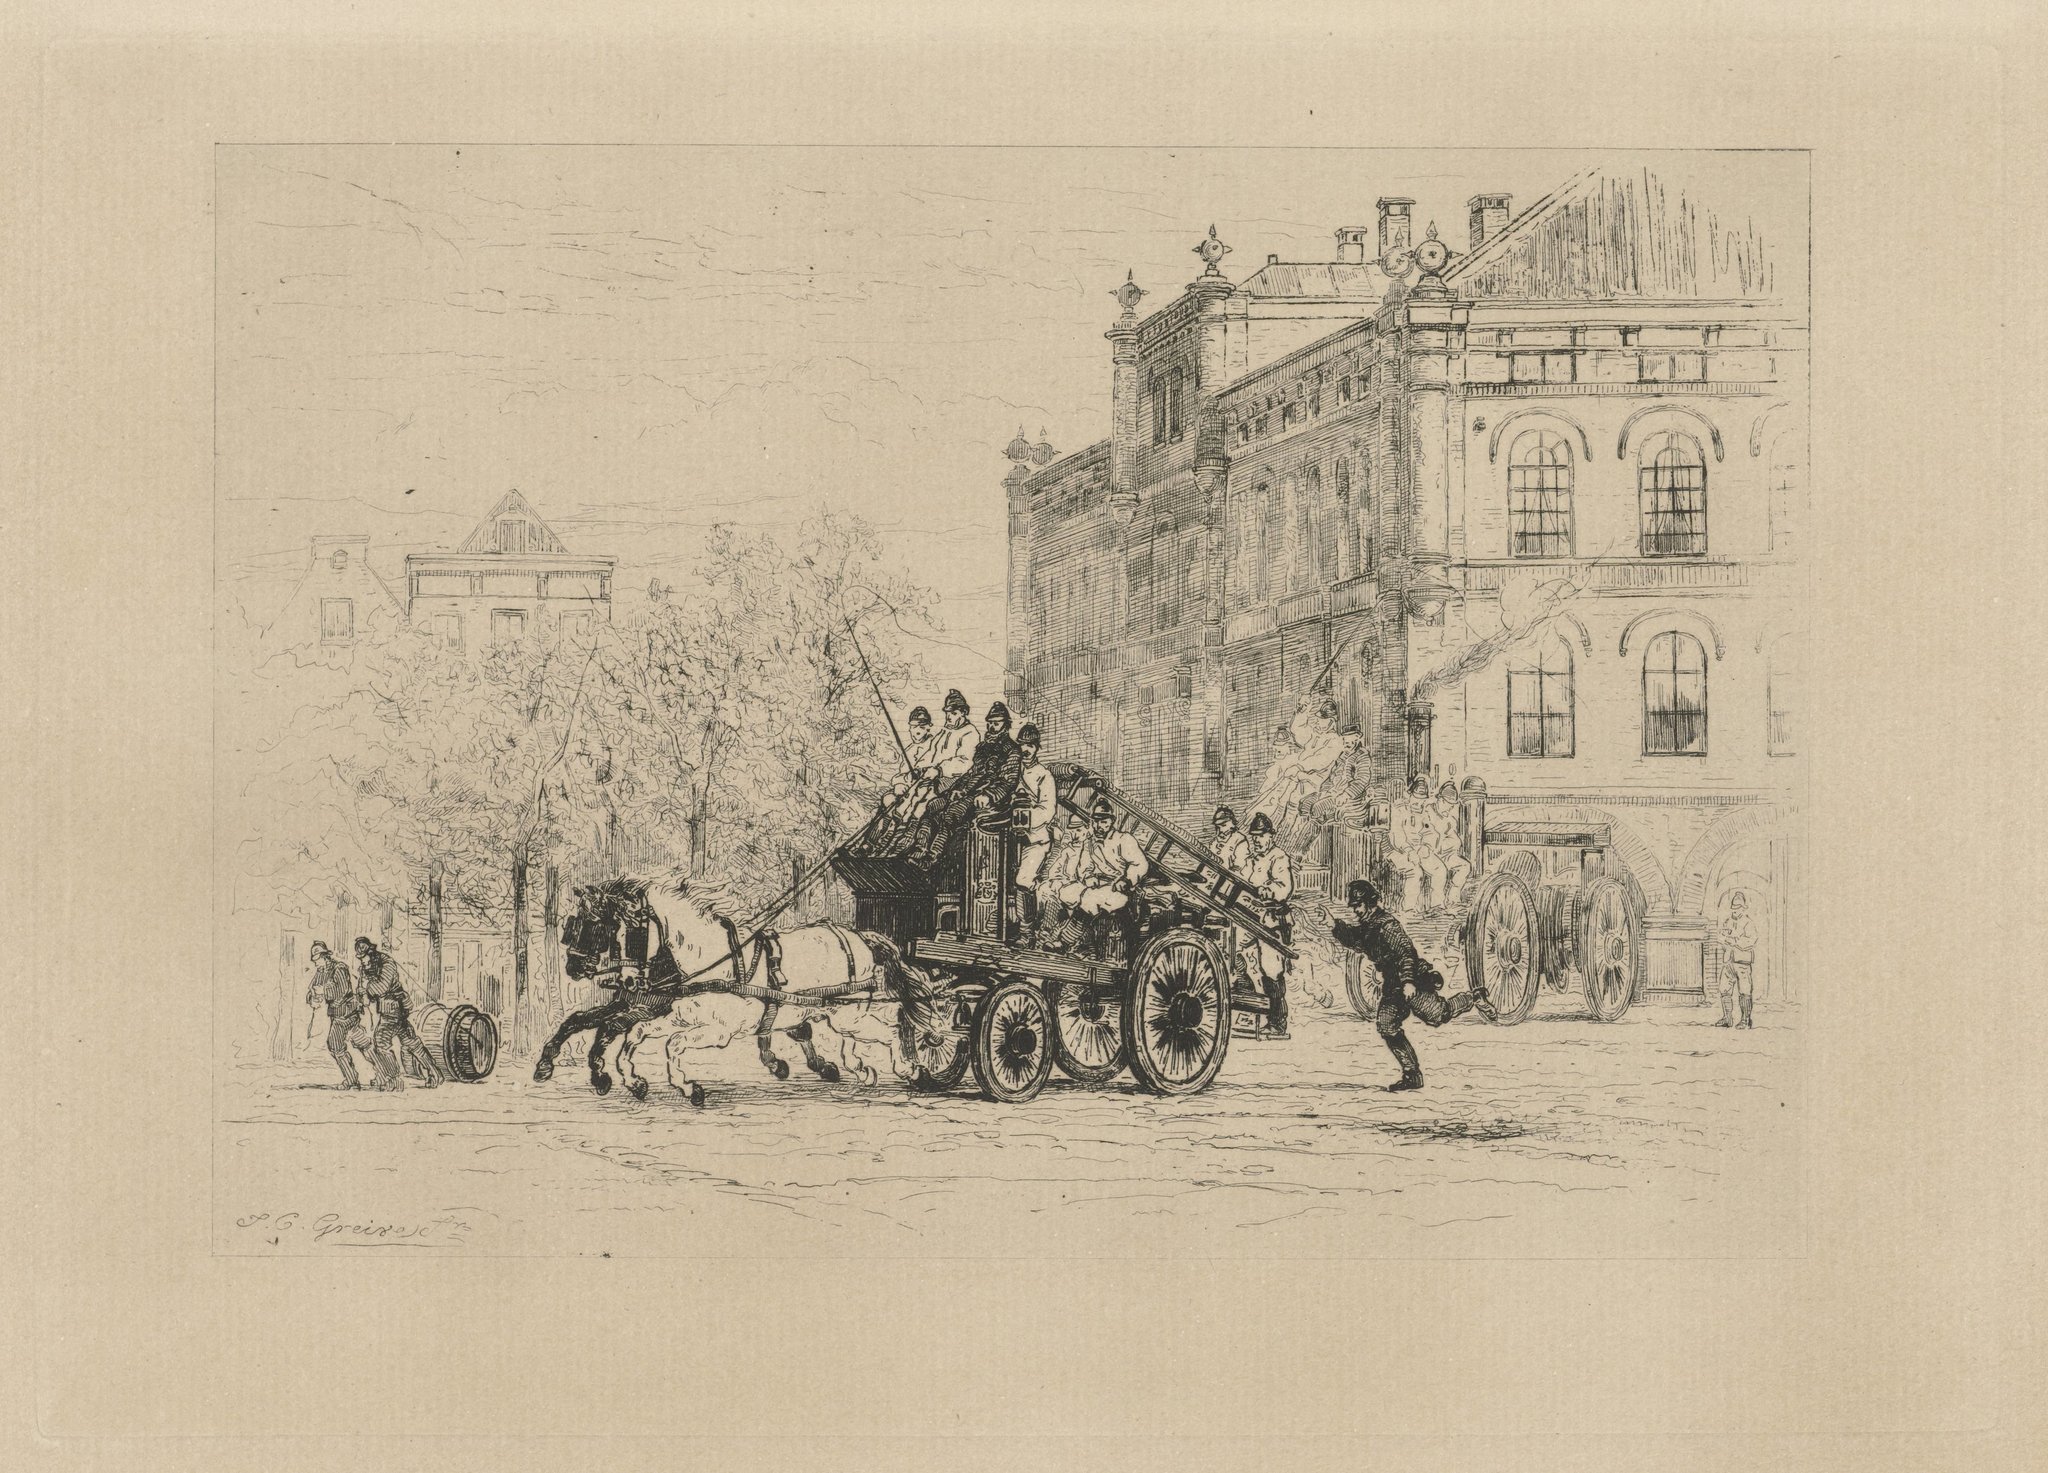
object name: print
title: Gezicht op het Weesperplein met een brandweerwagen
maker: johan conrad greive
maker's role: draughtsman, painter, print maker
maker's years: 1837-1891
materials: paper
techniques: etching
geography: amsterdam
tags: fire-engine, amsterdam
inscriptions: collector's mark: Lugt 2228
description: Het Weesperplein met de brandweerkazerne. Op de voorgrond de door paarden getrokken brandweerwagen.